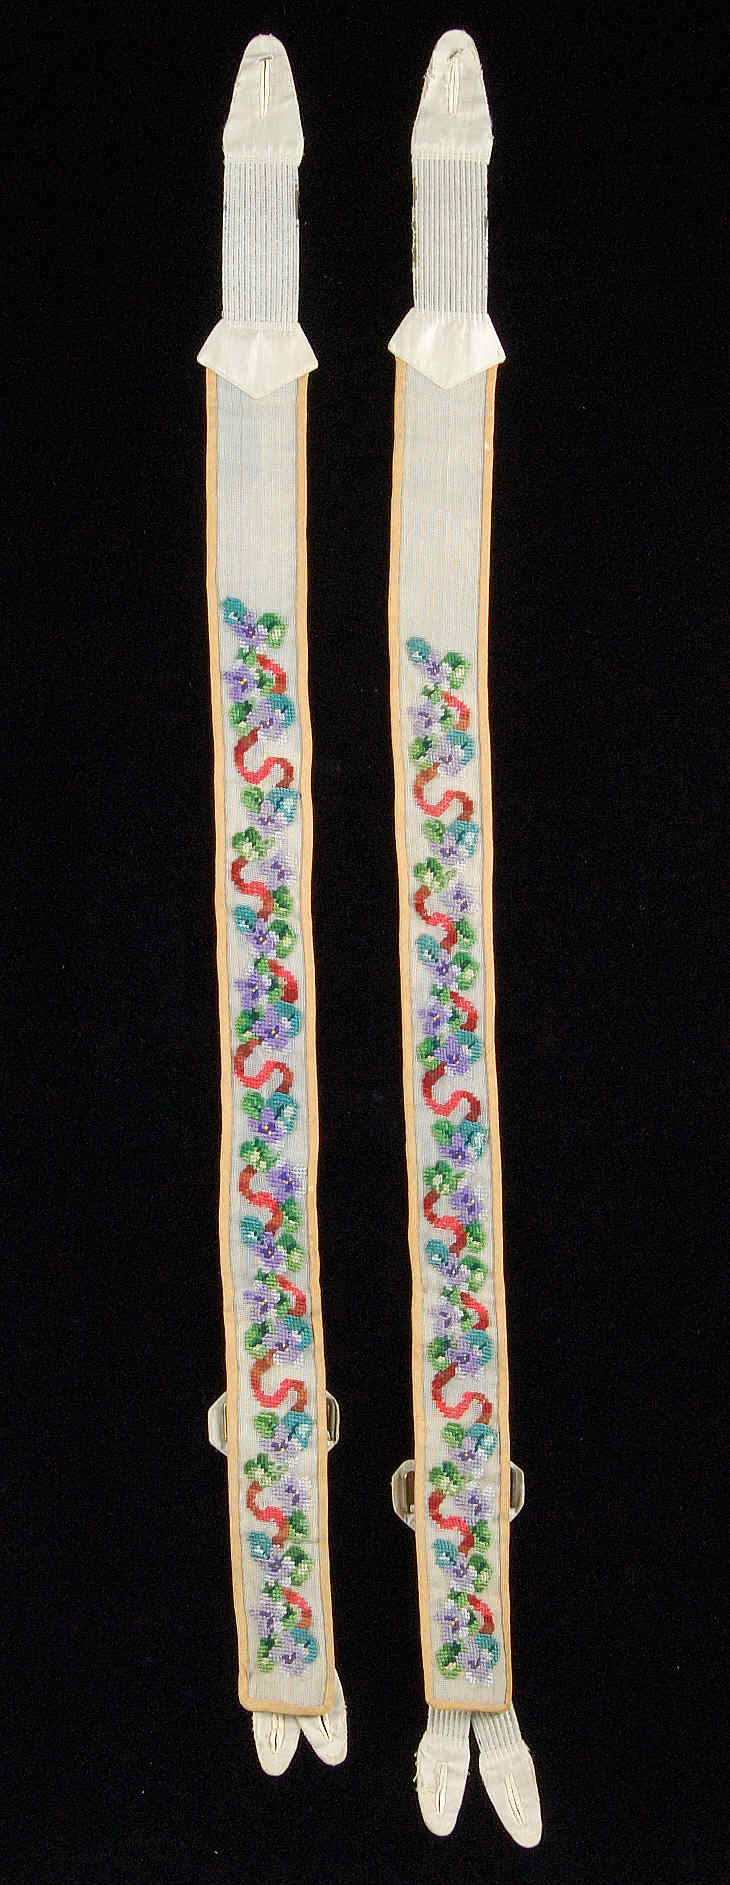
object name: suspender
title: Suspenders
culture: american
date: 1880-1899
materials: leather, silk